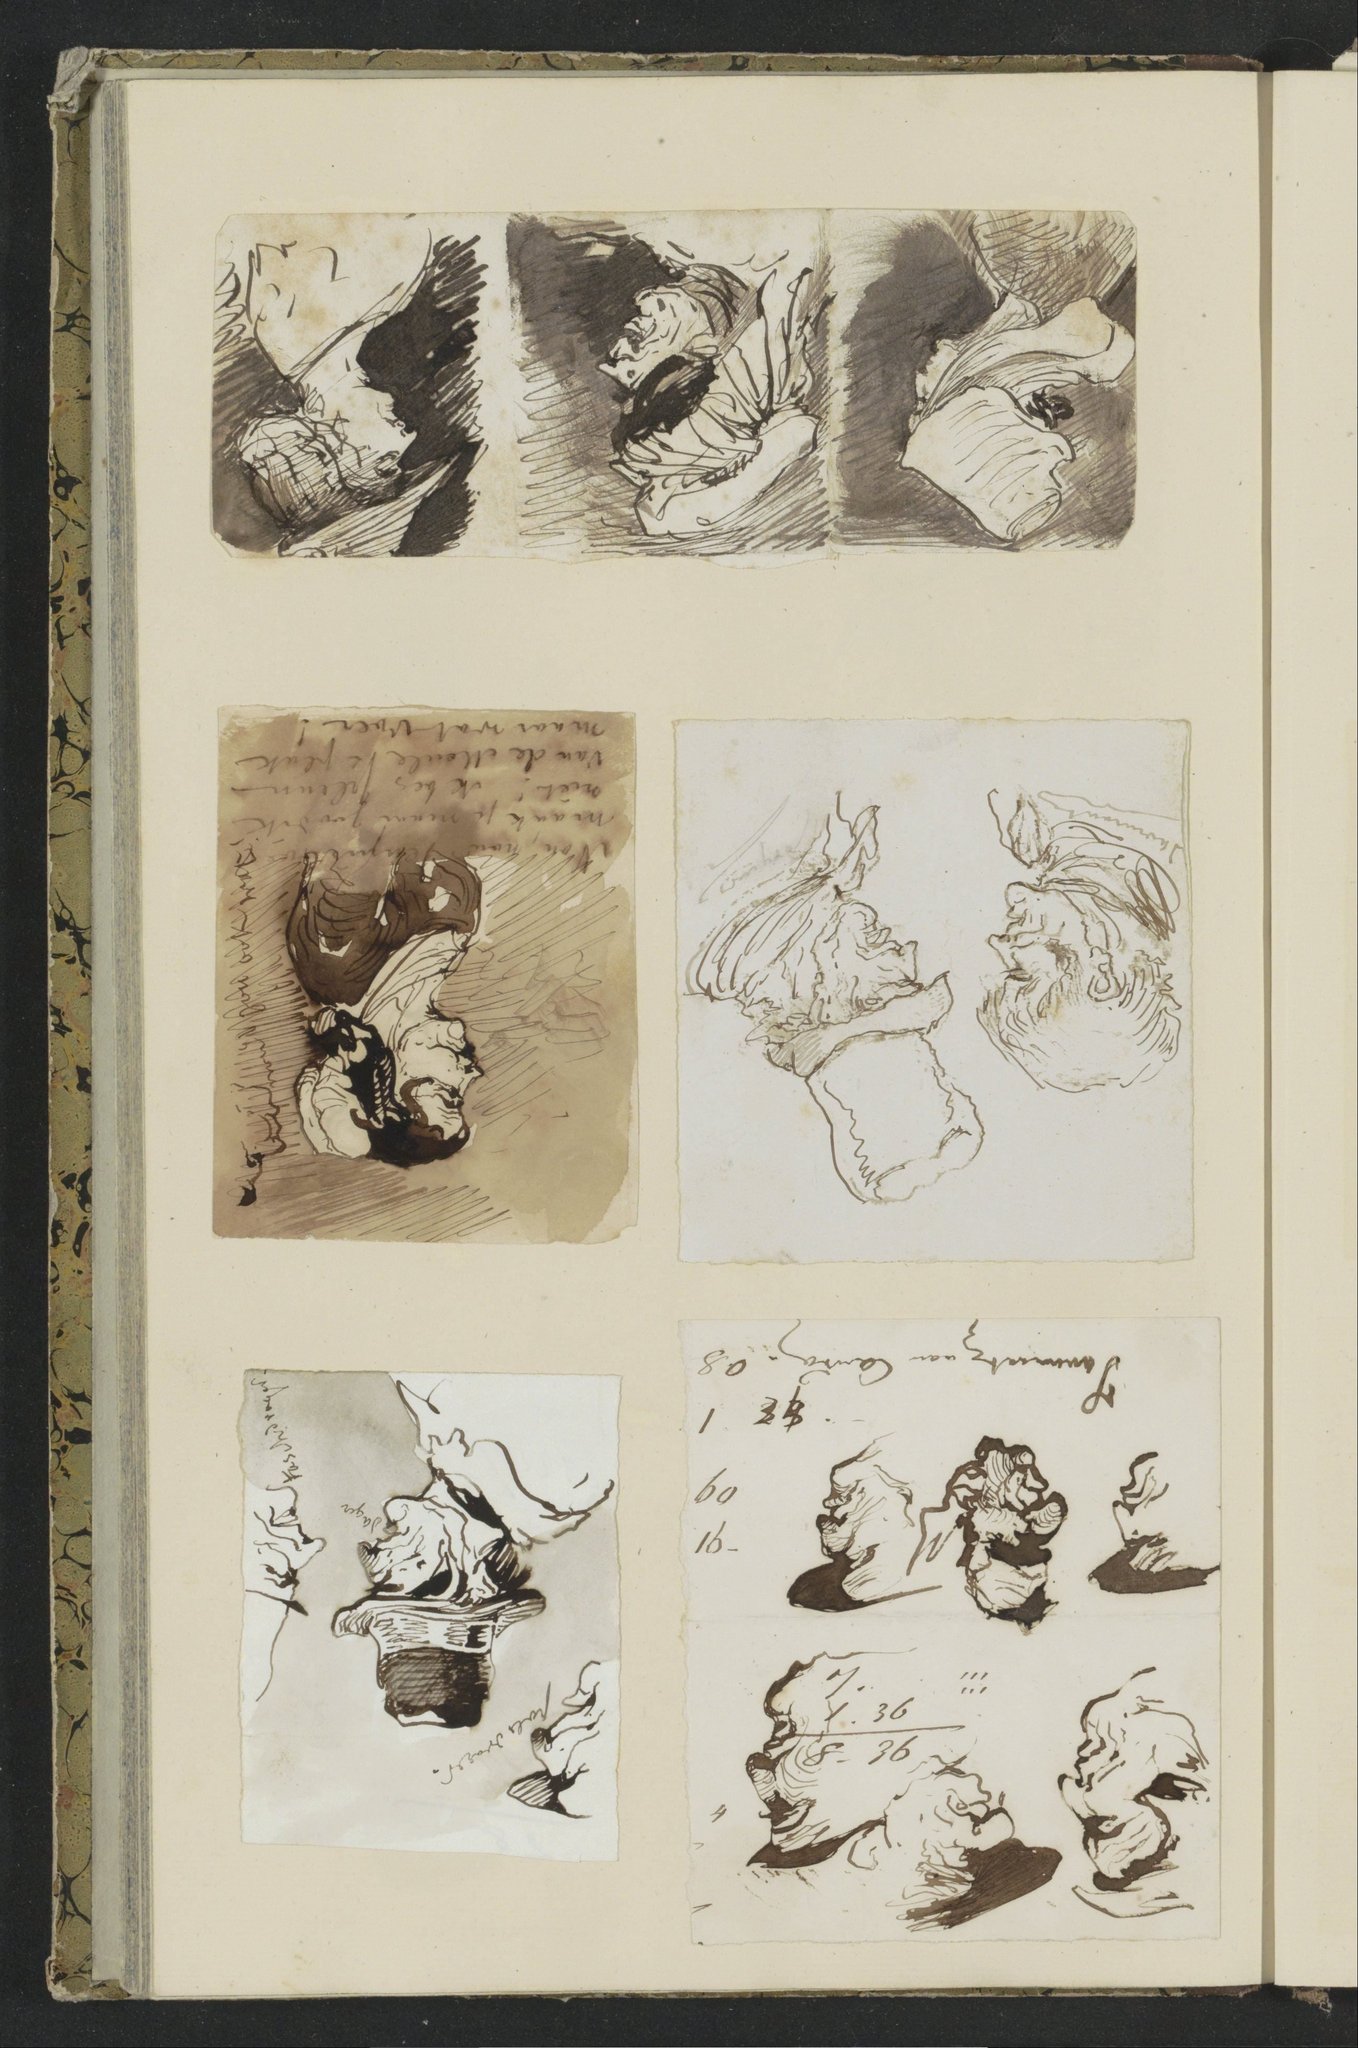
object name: sketchbook leaf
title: Mannen- en vrouwenkoppen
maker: johannes antonius canta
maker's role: draughtsman, painter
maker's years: 1816-1888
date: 1826-1888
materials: ink, paper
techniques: pen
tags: head (human), adult woman, head-gear: cap (+ men's clothes), adult man, head-gear: hat (+ women's clothes)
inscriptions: annotation: ‘Tavenraat aan Canta/ poesdrager/ jager/ taschdrager/ [...]’, signature and date: ‘Tavenraat/ 19/12 69/ voor de jenever/ na de jenever/ op de Heide’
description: Vijf ingeplakte schetsen met karikaturen van mannen en vrouwen. Vermoedelijk stuurde Tavenraat deze naar Canta. Op de verso-zijde van de schets rechts in het midden een mannenkop. Blad 43 verso uit een schetsboek en album met 59 bladen.